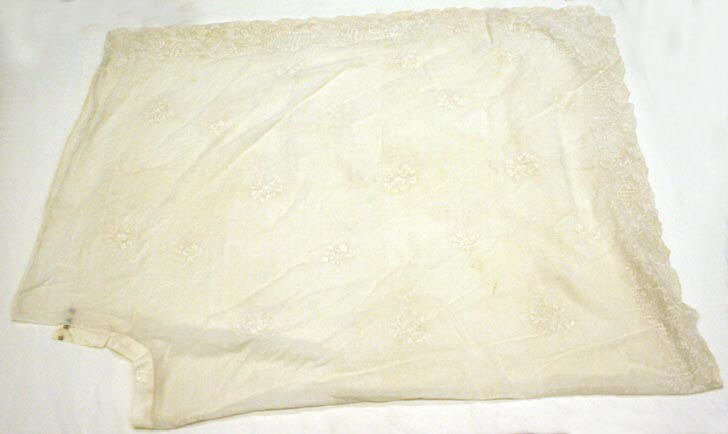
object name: accessory set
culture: british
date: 1750-1775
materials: cotton